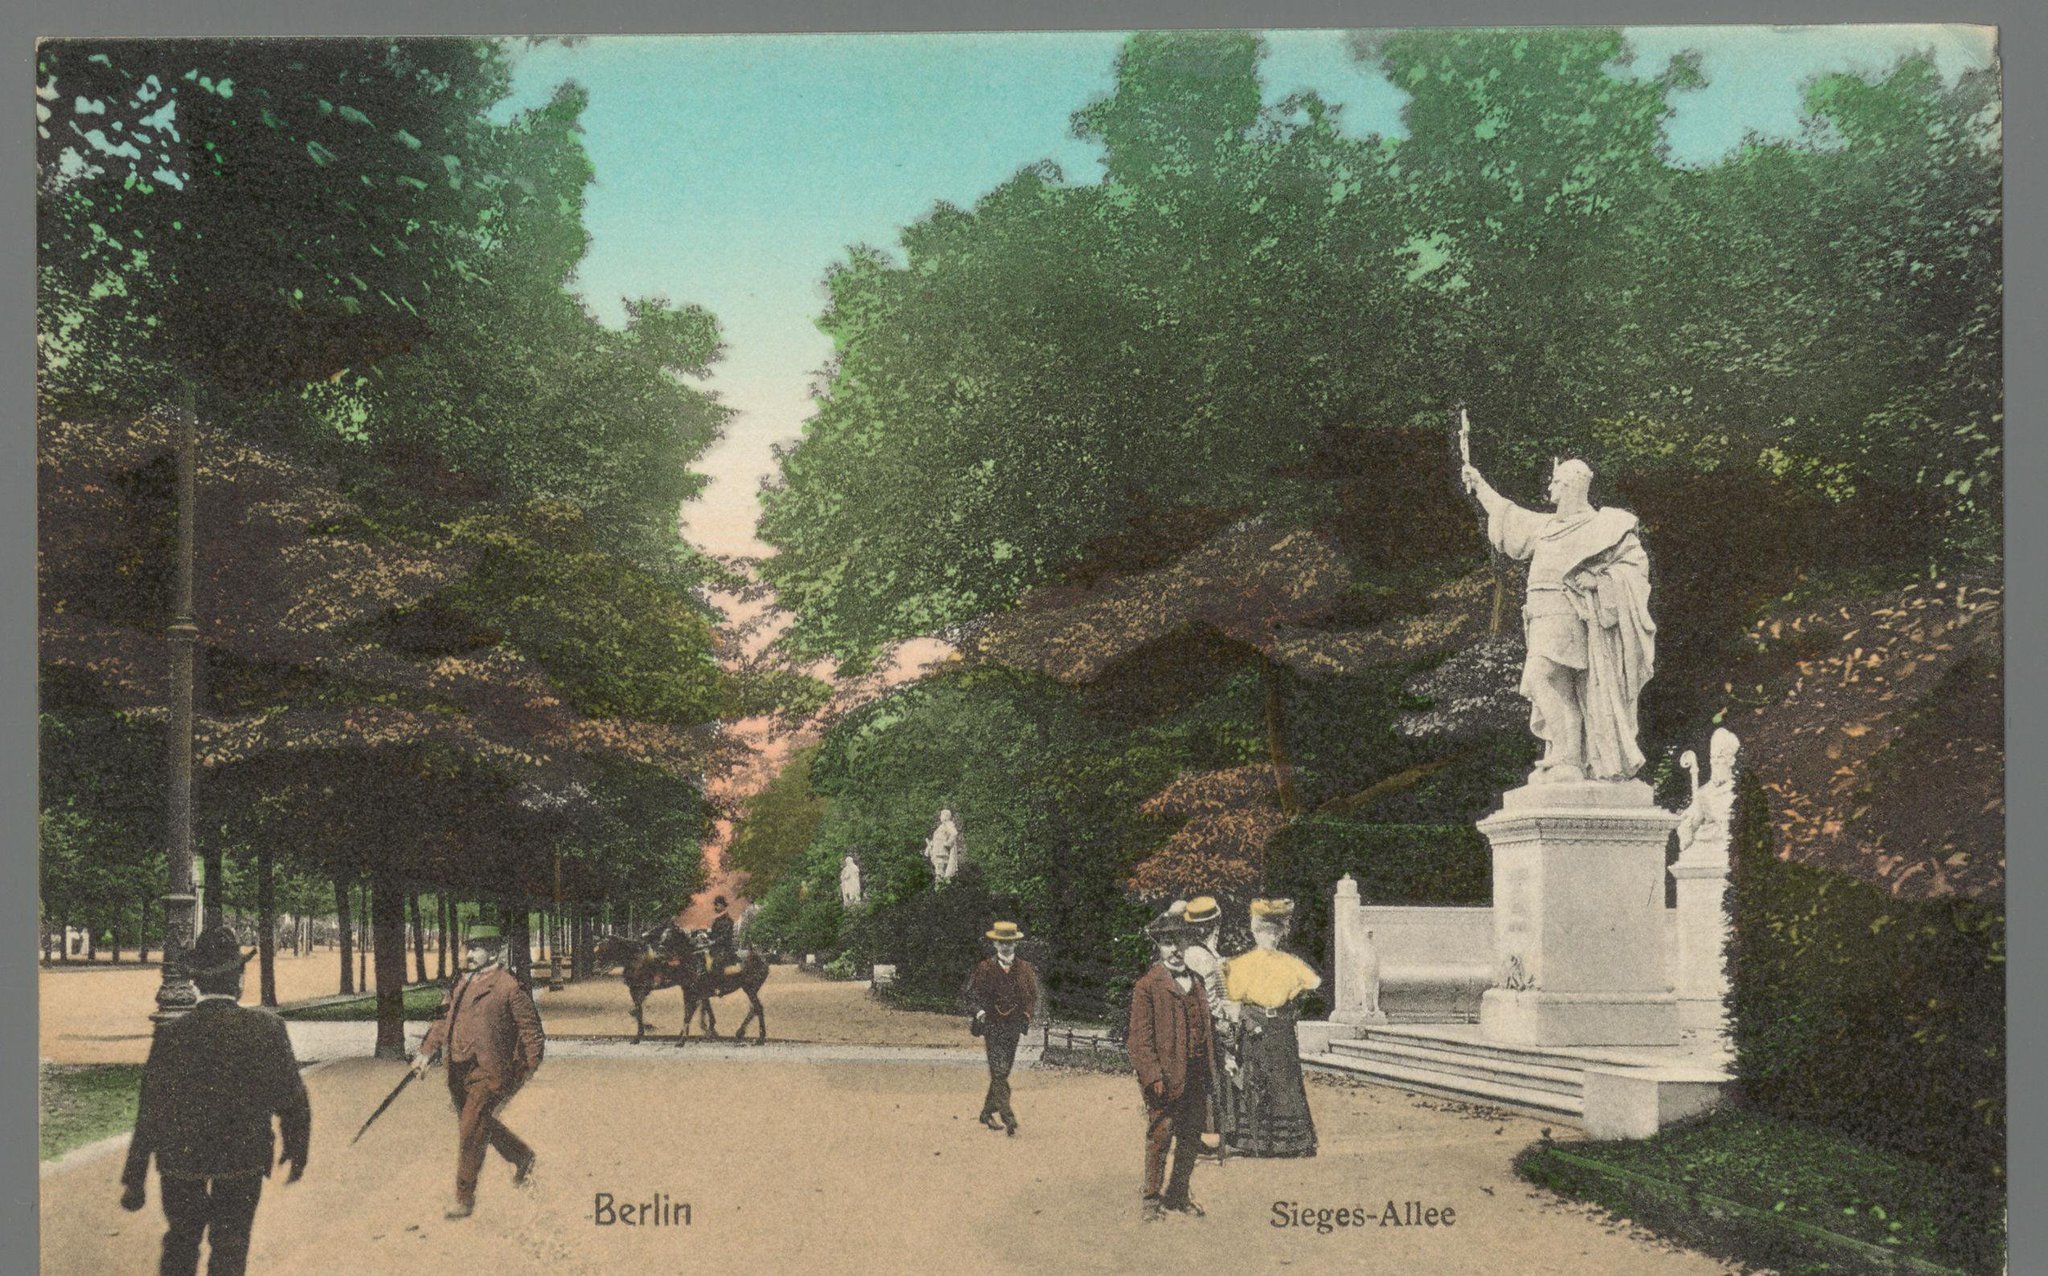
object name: photomechanical print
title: Berlin. Sieges-Allee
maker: Anonymous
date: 1905-1909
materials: cardboard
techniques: photograph, lithograph, writing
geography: berlin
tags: monument, statue, avenue, boulevard, promenade, esplanade